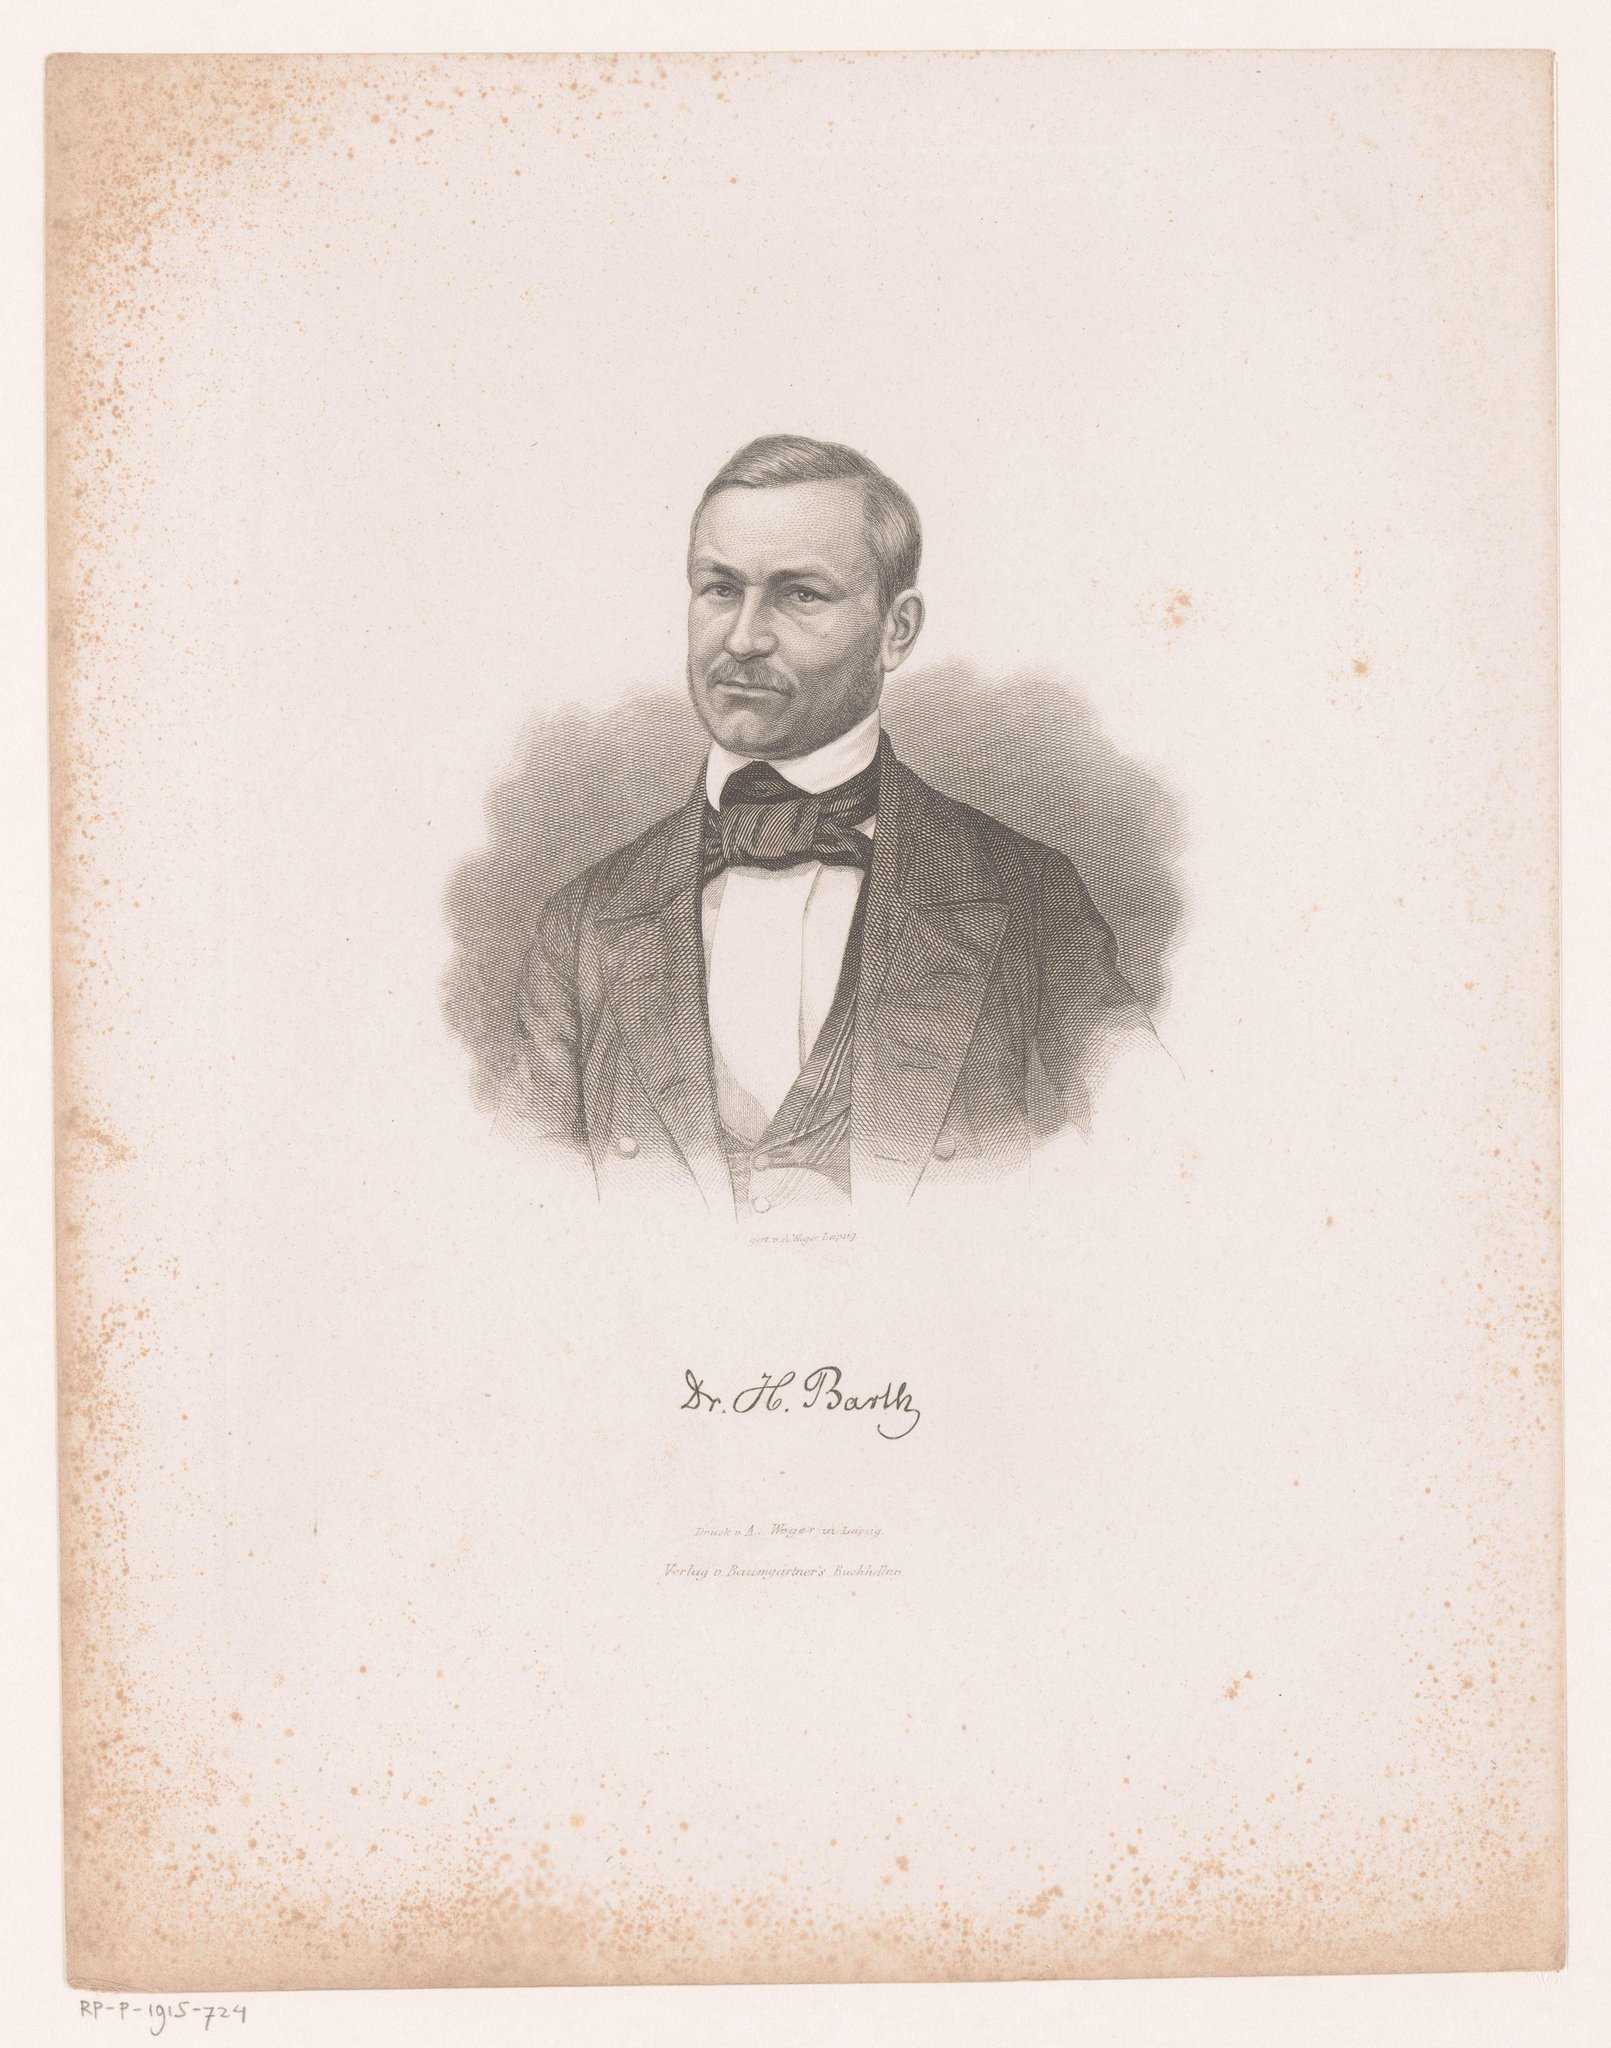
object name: print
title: Portret van Heinrich Barth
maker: august weger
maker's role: print maker, printer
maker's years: 1823-1892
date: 1850-1892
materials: paper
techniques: engraving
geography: leipzig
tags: historical persons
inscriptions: collector's mark: Lugt 2228